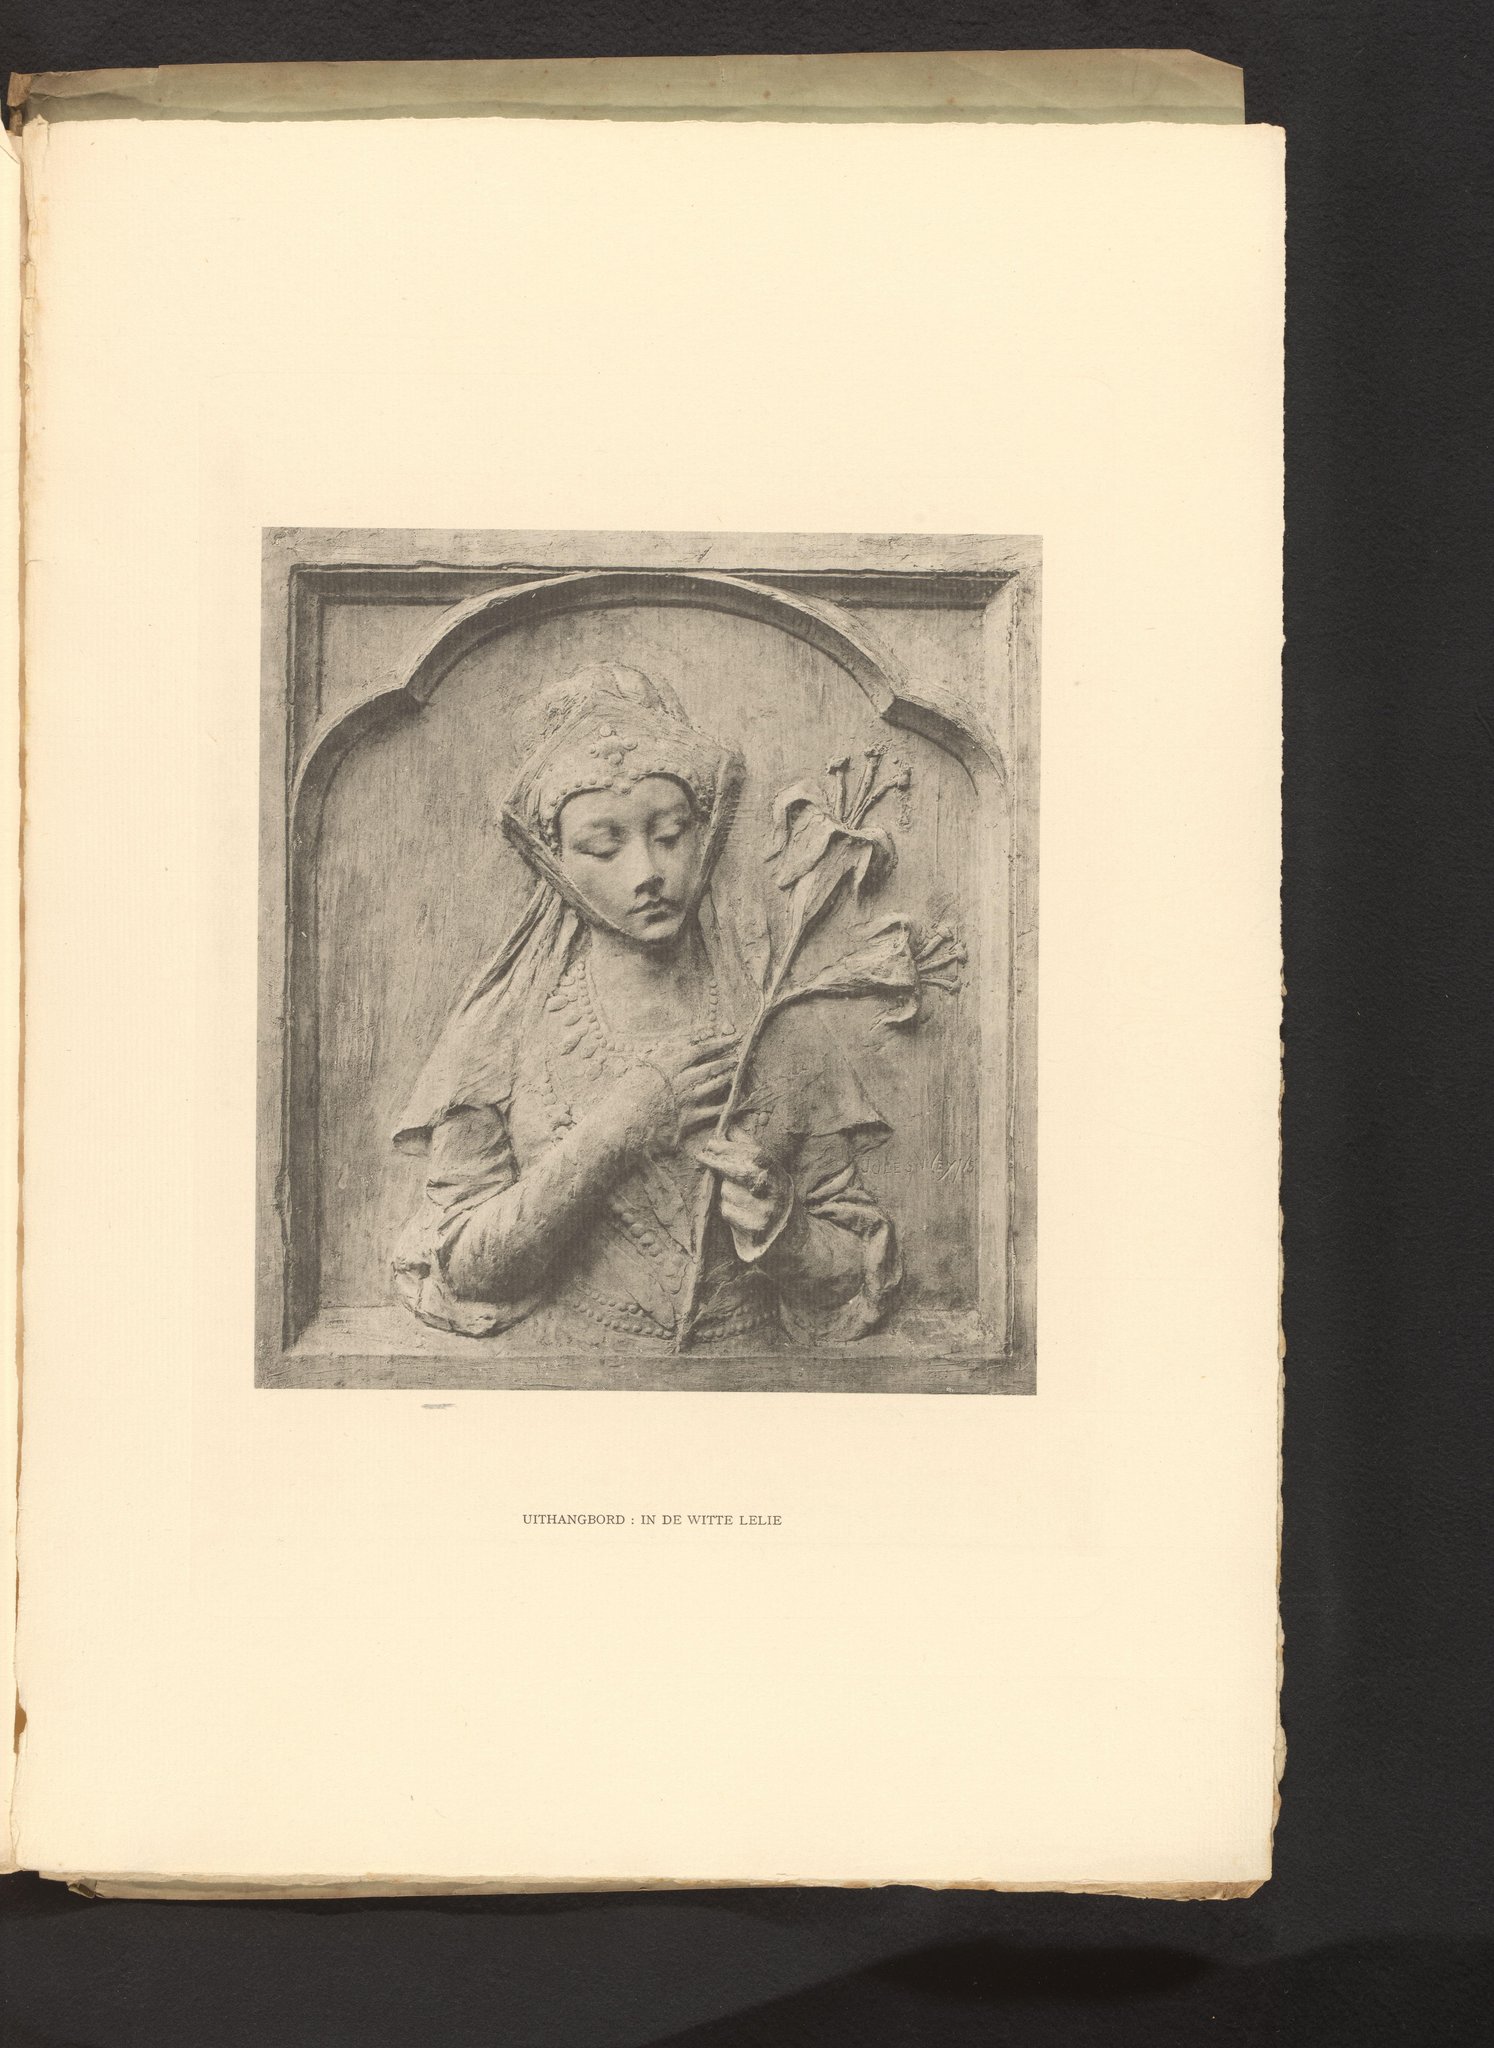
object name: page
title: Uithangbord: in de witte lelie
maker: Anonymous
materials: paper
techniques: photograph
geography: antwerp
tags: world fair, world exhibition, piece of sculpture, reproduction of a piece of sculpture, antwerp